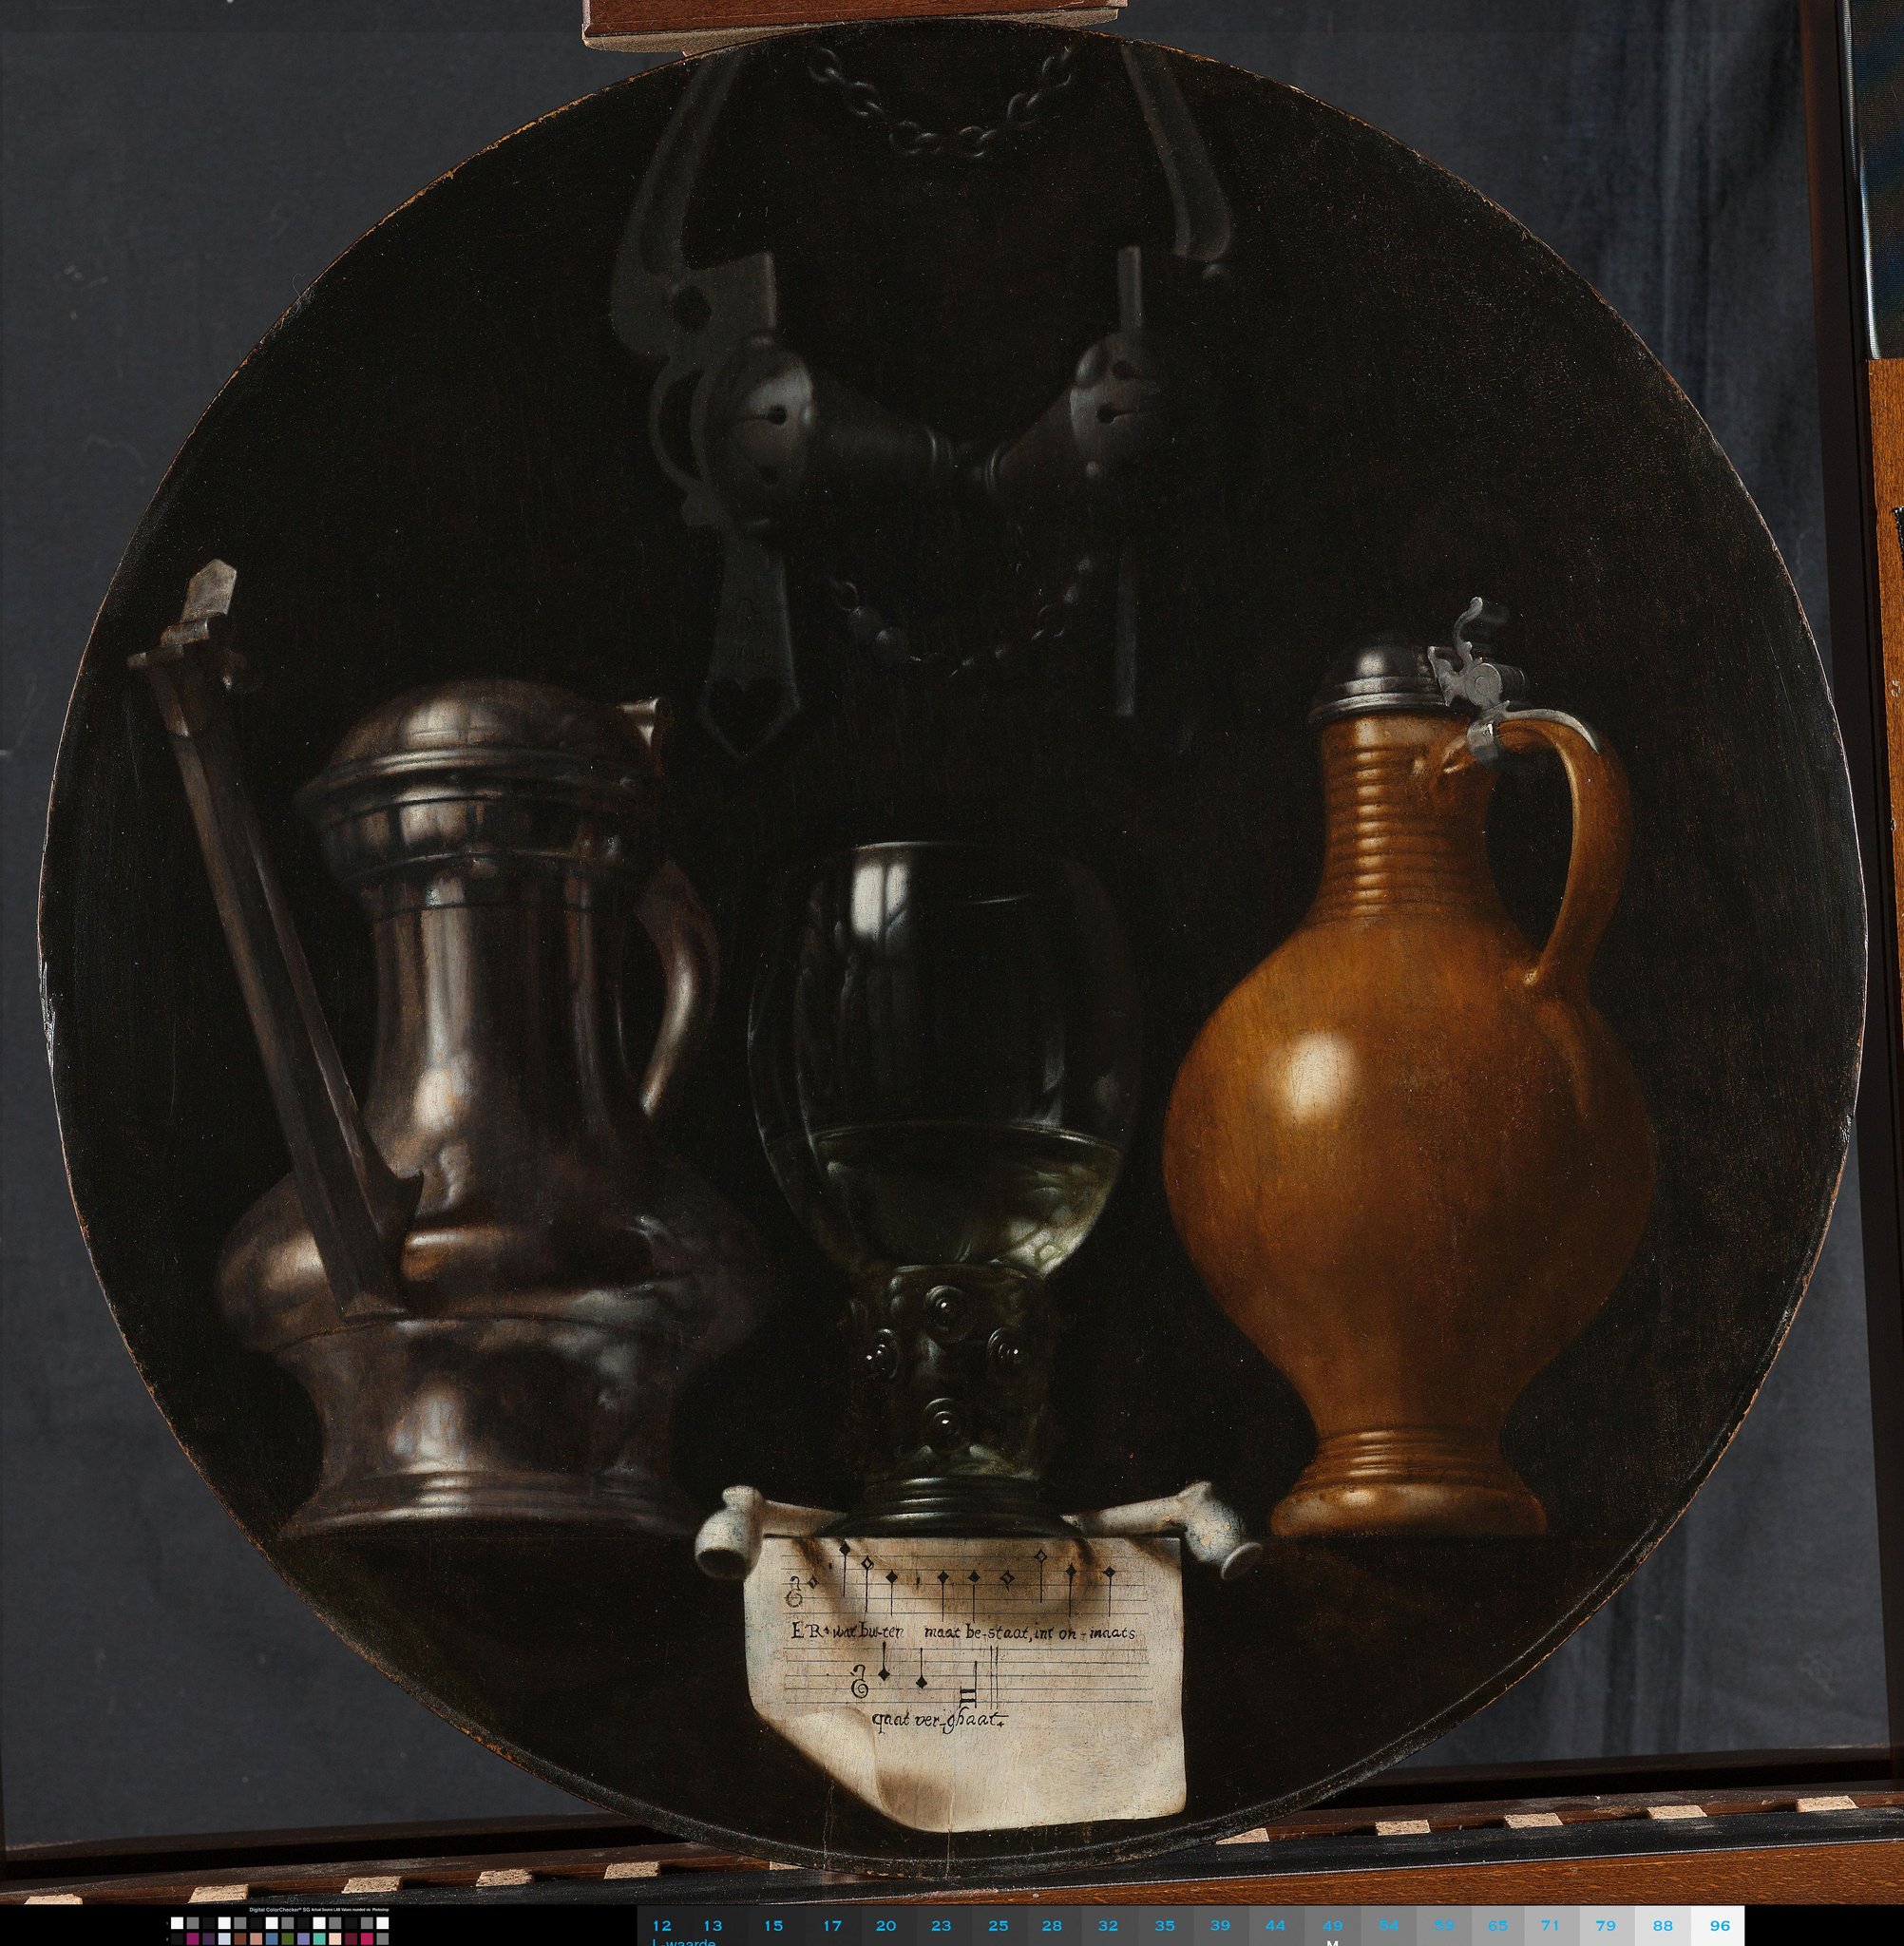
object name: painting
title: Emblematic still life with flagon, glass, jug and bridle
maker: johannes torrentius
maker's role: painter, print maker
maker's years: 1589-1644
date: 1614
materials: oil, panel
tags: pipe ~ tobacco, still life of related objects, drinking-vessels, temperance, moderation; 'misura' (ripa) (+ emblematical representation of concept)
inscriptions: inscription, bottom centre, on the paper: ‘ER * wat bu-ten maat be-staat, int on-maats qaat ver-ghaat*’, signature and date, on the bit on the left (with ligated monogram): ‘JT / 1614’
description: A pewter flagon, a wine glass, an earthenware jug, a bridle or rein, and a piece of paper with two staves and inscribed ‘what is out of measure, perishes in immeasurable evil.’ These are exhortations to moderation. You must cut wine with water, curb your appetites. This strict message contrasts sharply with the reputation of the painter, who was repeatedly accused of whoremongery and heresy.